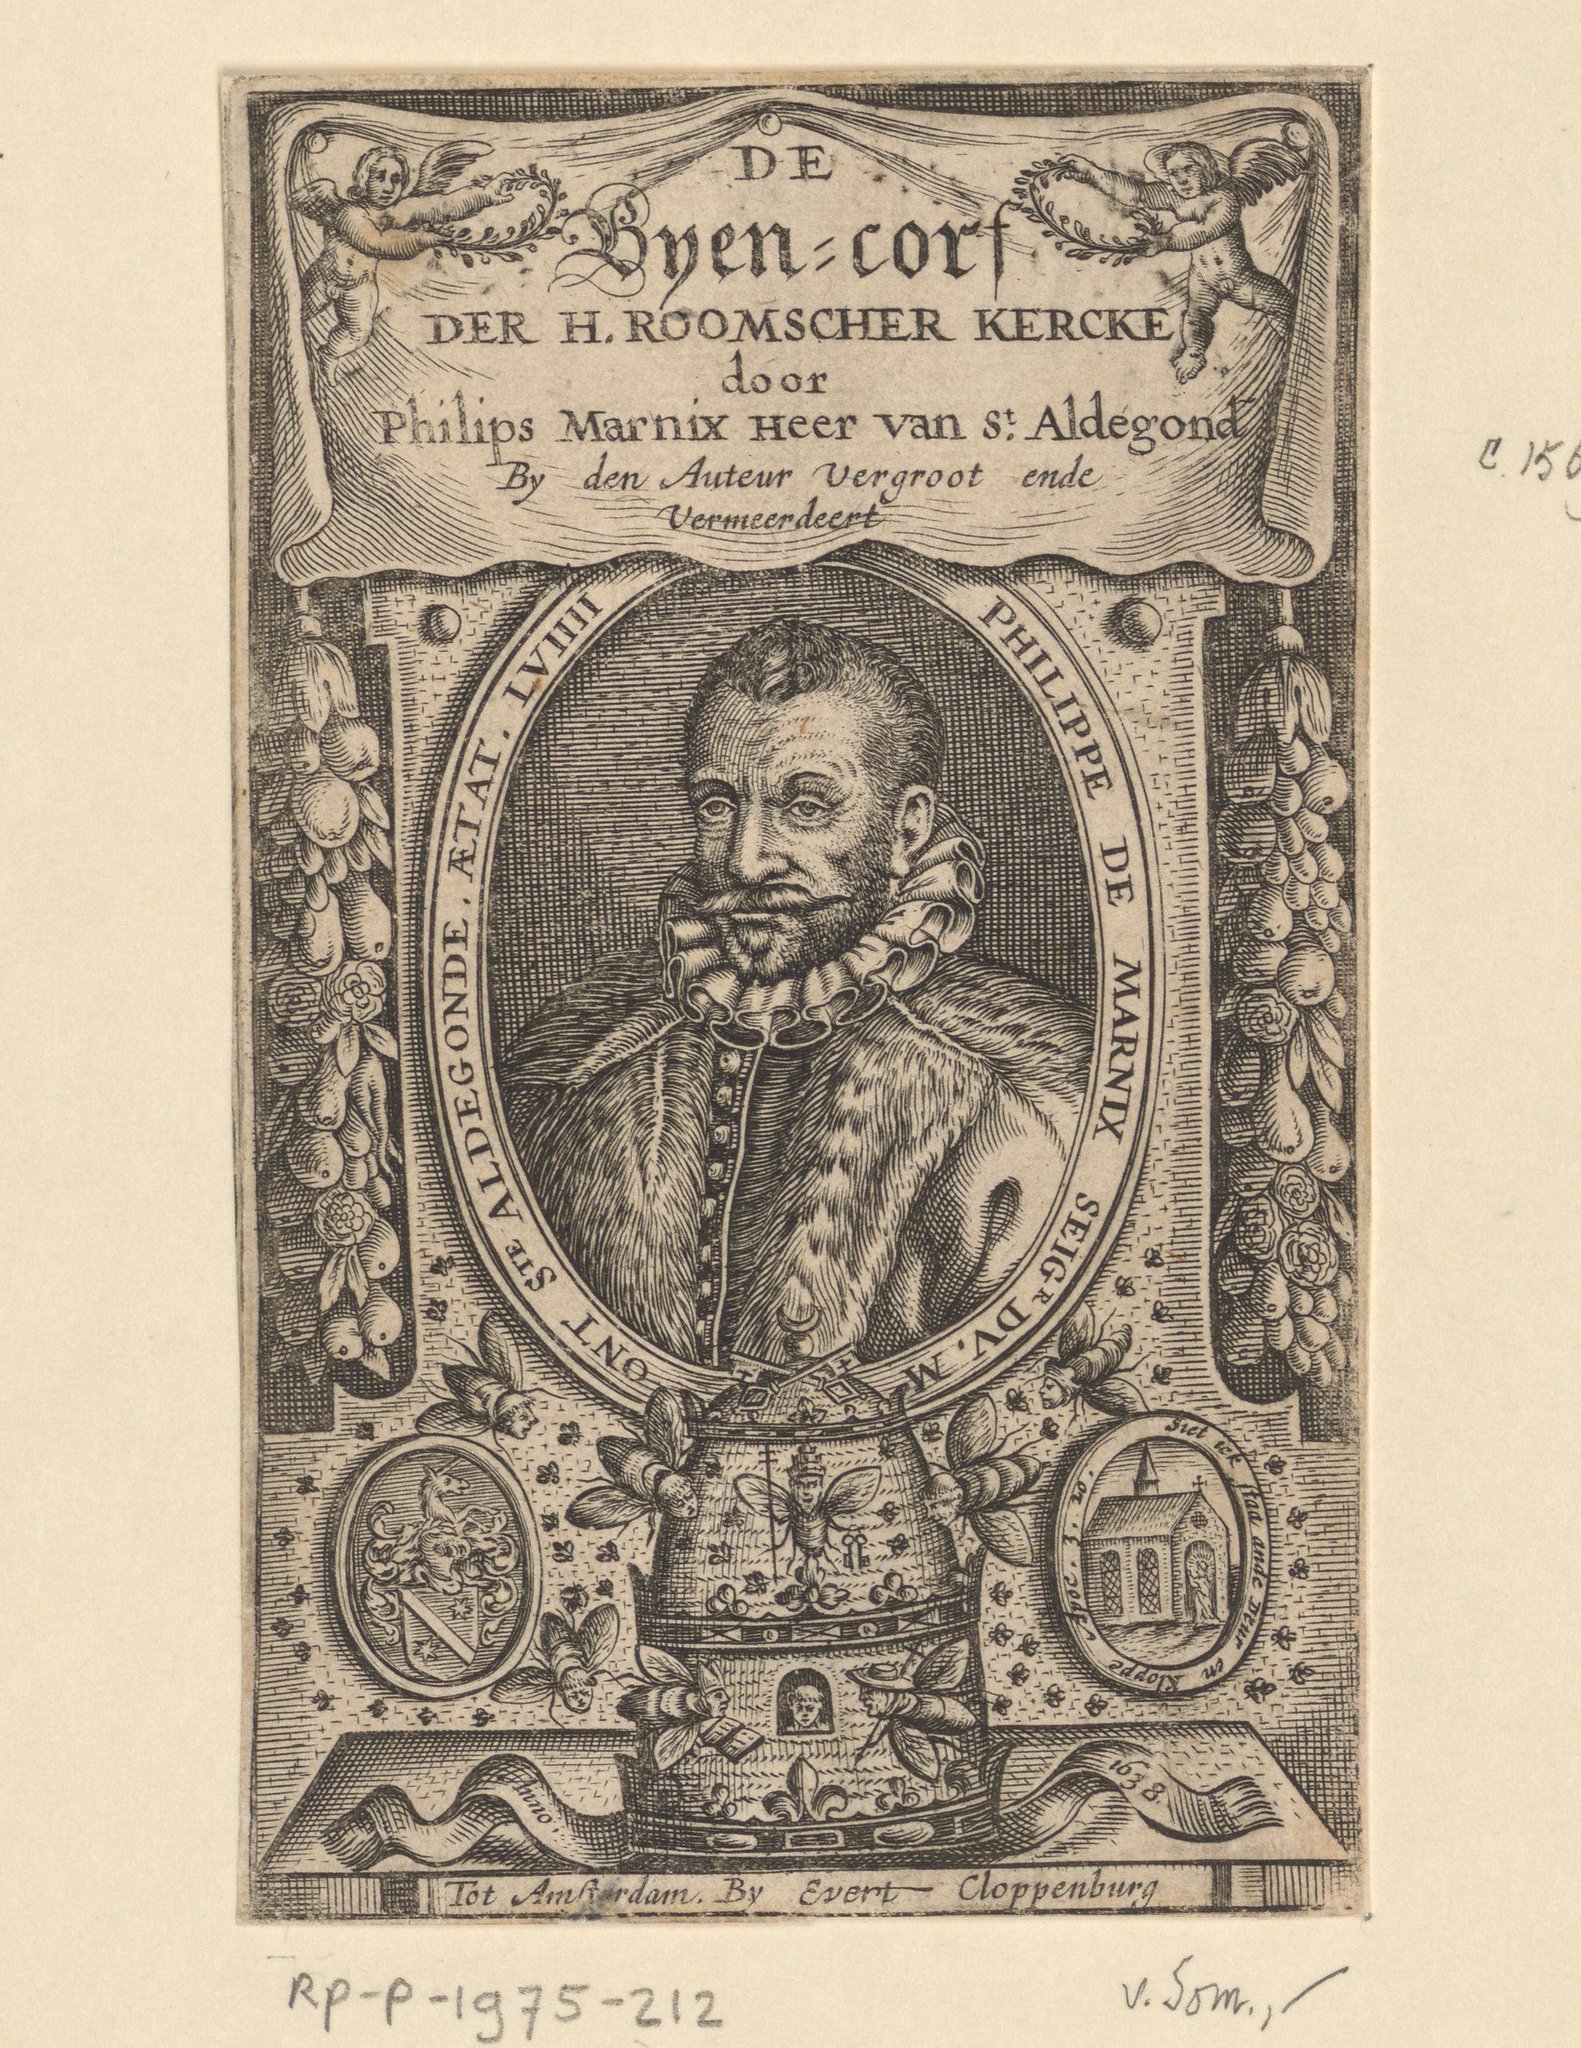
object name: print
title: Titelpagina voor: Filips van Marnix, De Byen-corf der H. Roomscher Kercke, 1638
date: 1638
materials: paper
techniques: engraving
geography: amsterdam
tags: brussels, leiden, politician, filips van marnix van sint-aldegonde, ornament ~ medallion, insignia of the pope, e.g. tiara, historical persons, portrait of a writer, bee-hive, armorial bearing, heraldry, the roman catholic church vs. protestantism; (reformation and counter reformation)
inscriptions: collector's mark: Lugt 2228, collector's mark: Lugt 2760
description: Titelpagina voor: Marnix van Sint-Aldegonde, Filips van. De Byen-corf der H. Roomscher Kercke. Amsterdam: Evert Cloppenburgh, 1638.